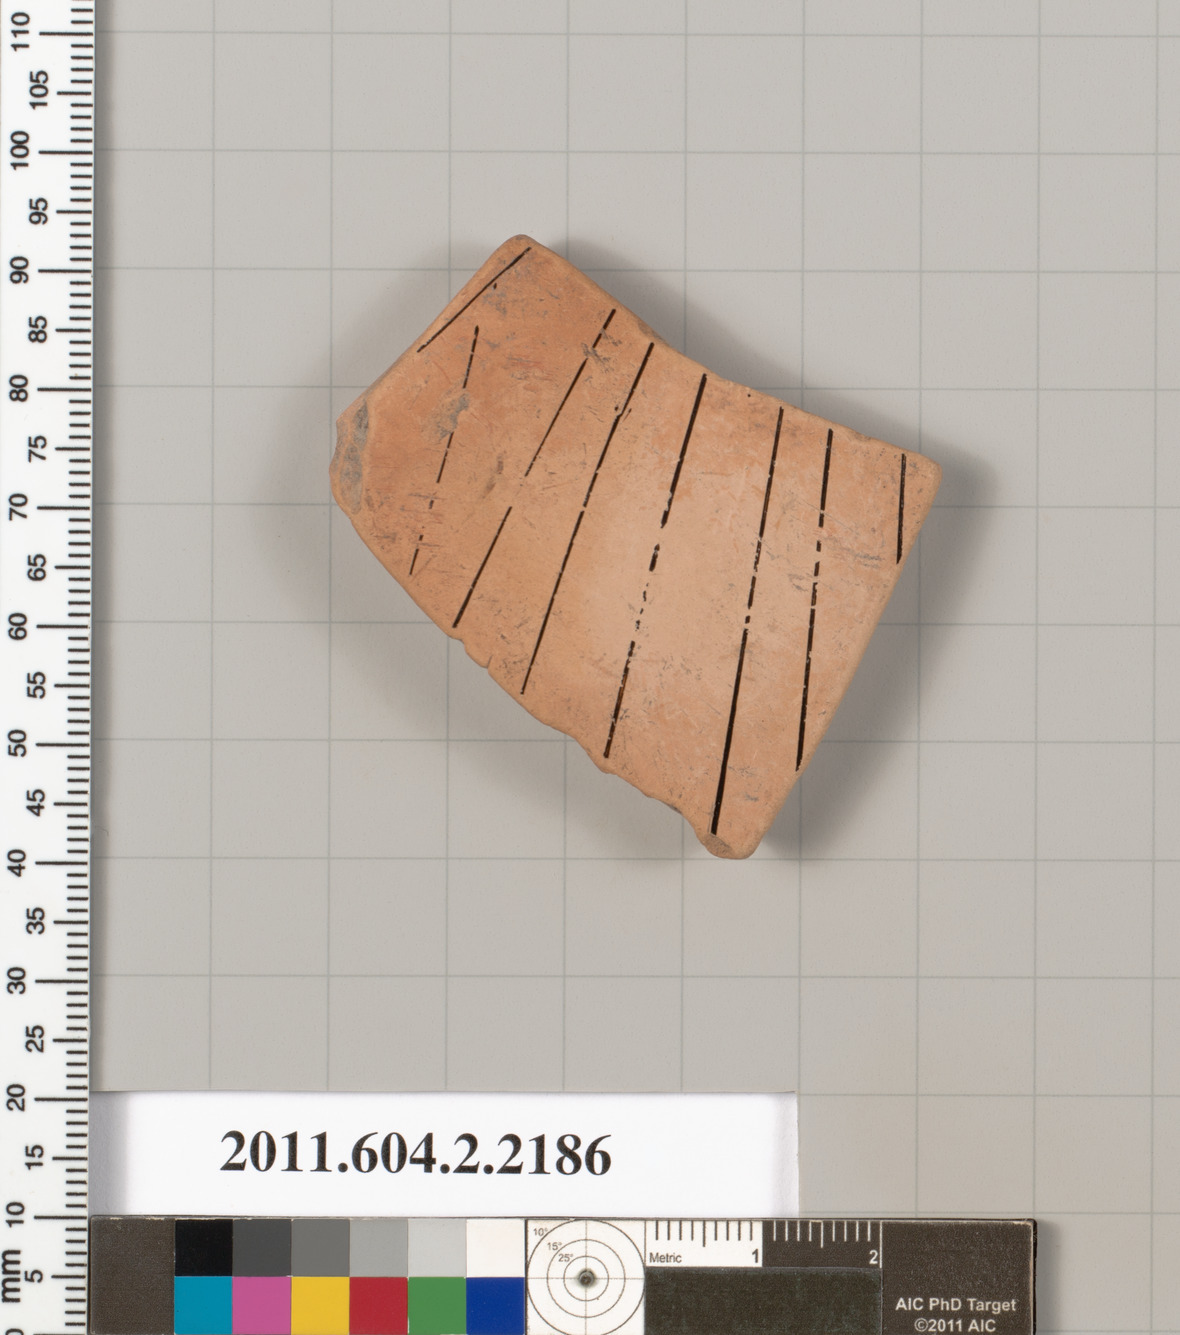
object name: pot fragment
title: Terracotta fragment of a pot; unglazed on the inside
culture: greek, attic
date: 475-451 BCE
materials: terracotta